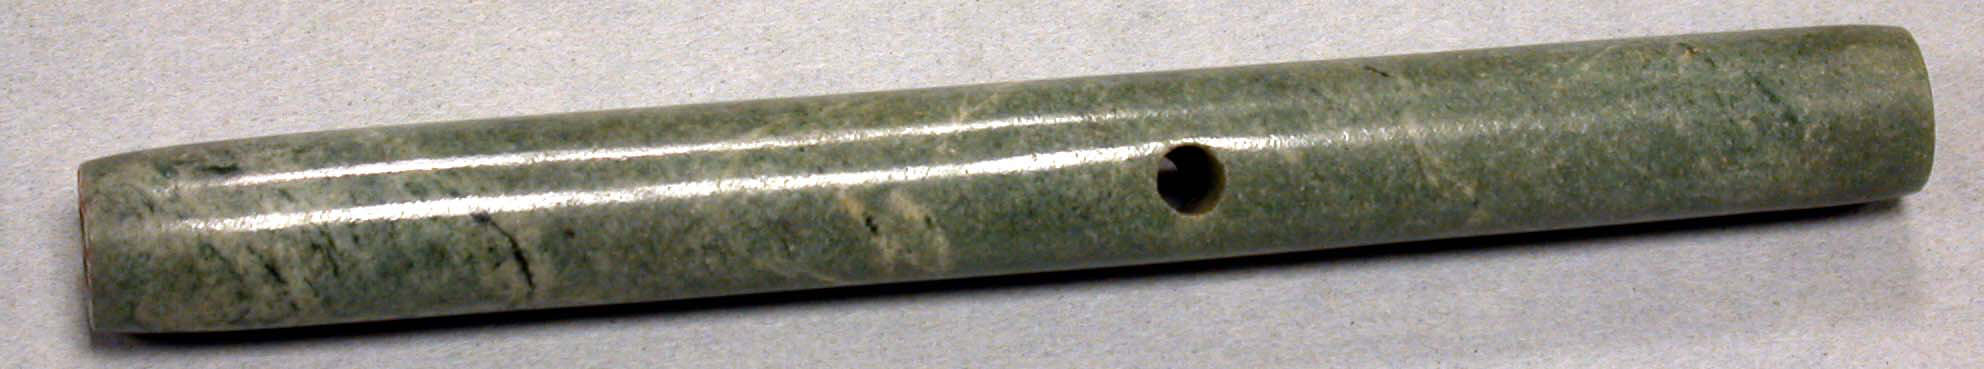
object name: bead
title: Tubular Stone Bead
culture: costa rican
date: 1501-1600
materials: stone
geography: costa rica